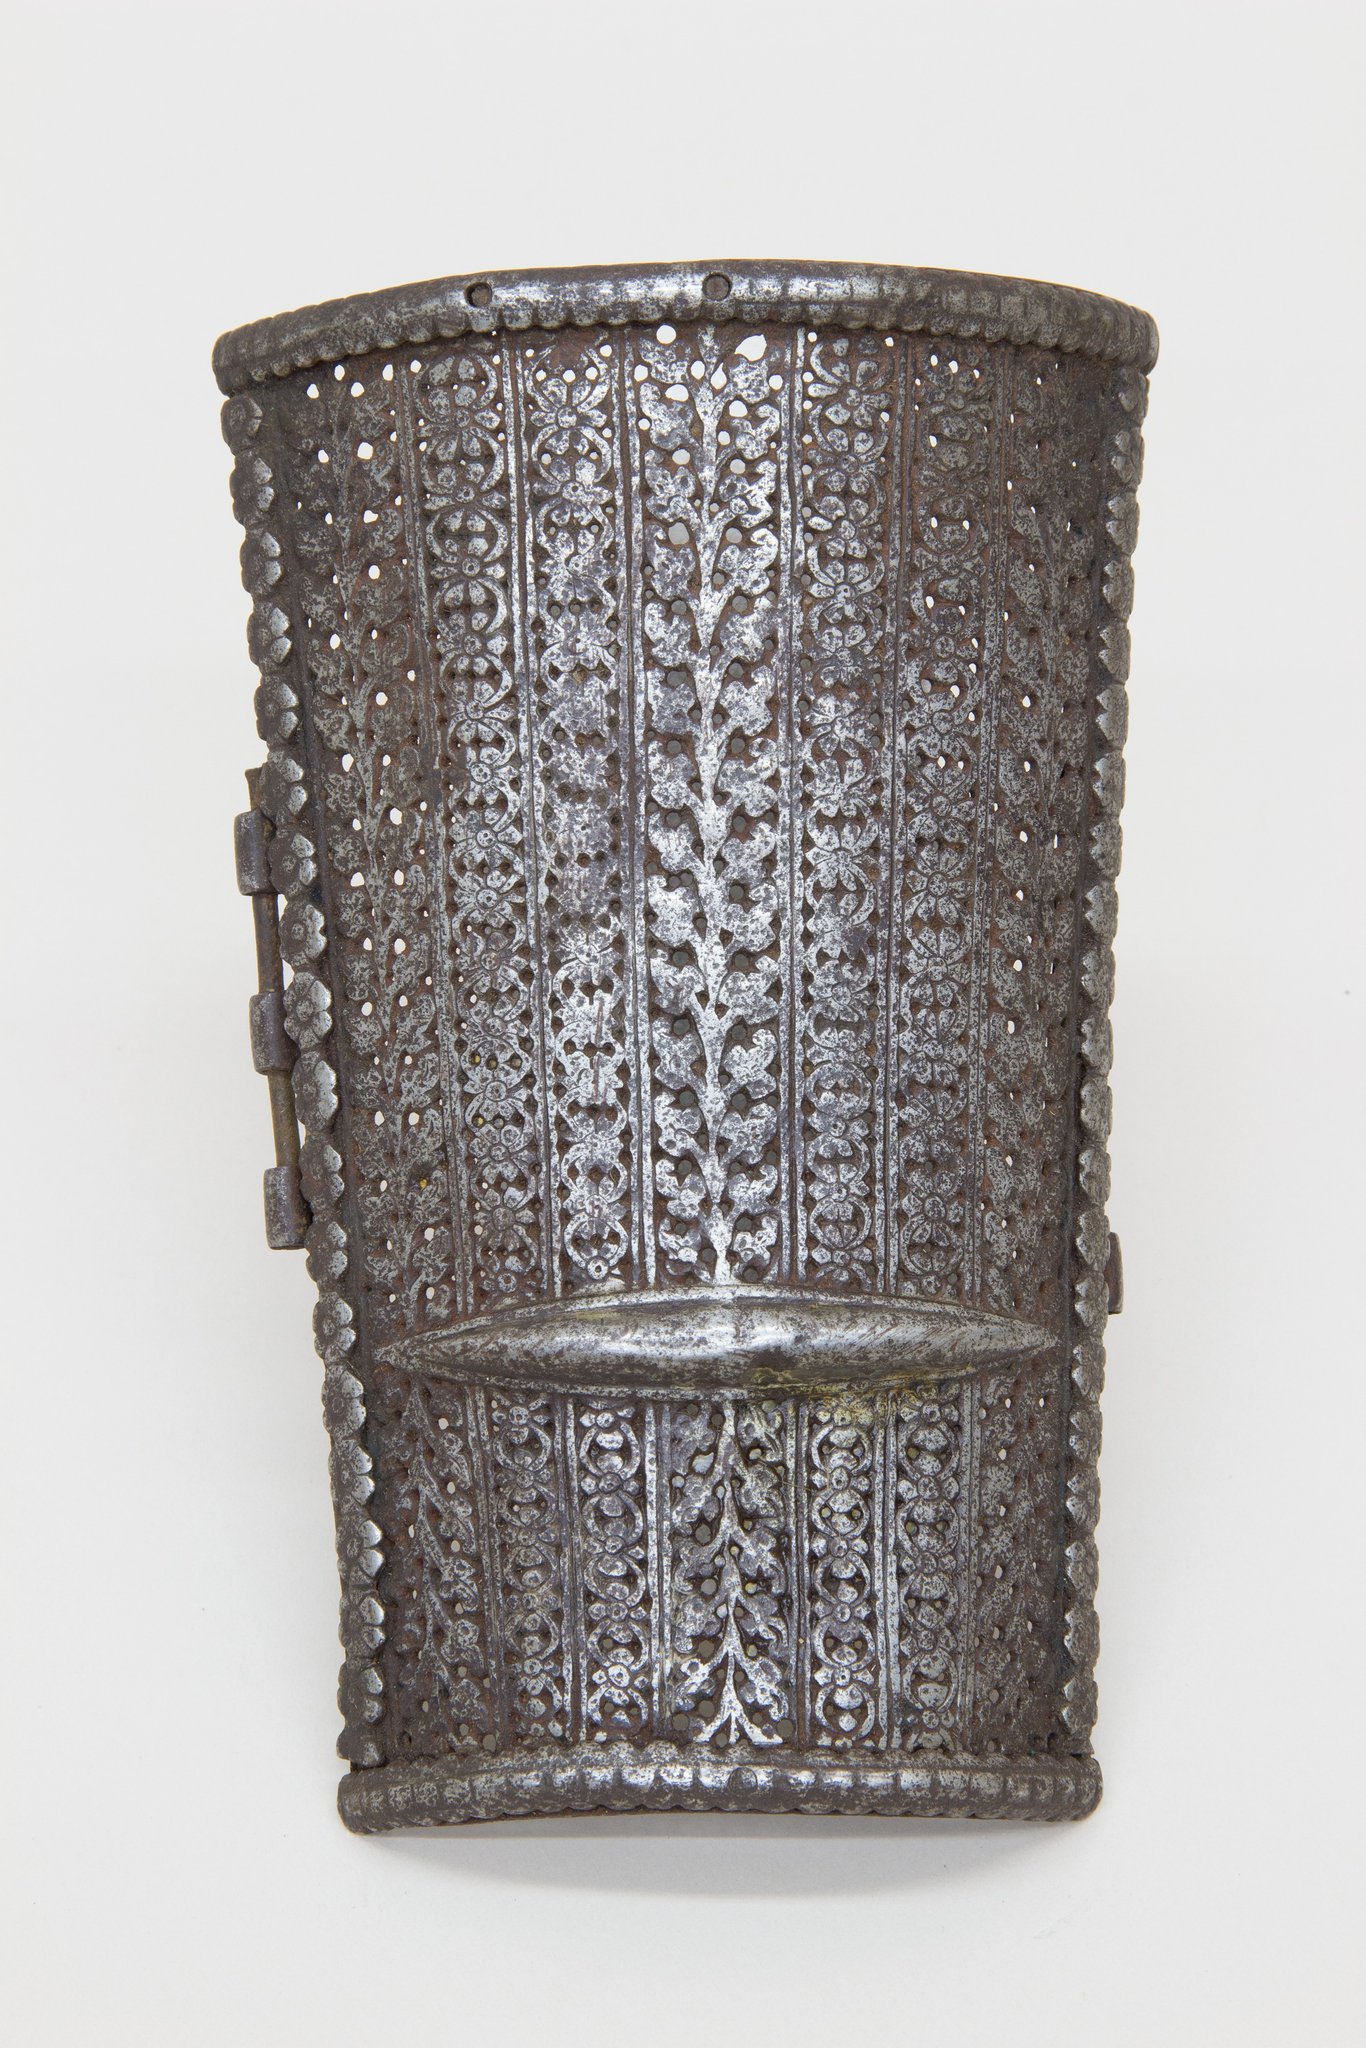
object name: inside lame of arm guard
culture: indian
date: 1601-1700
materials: steel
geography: india